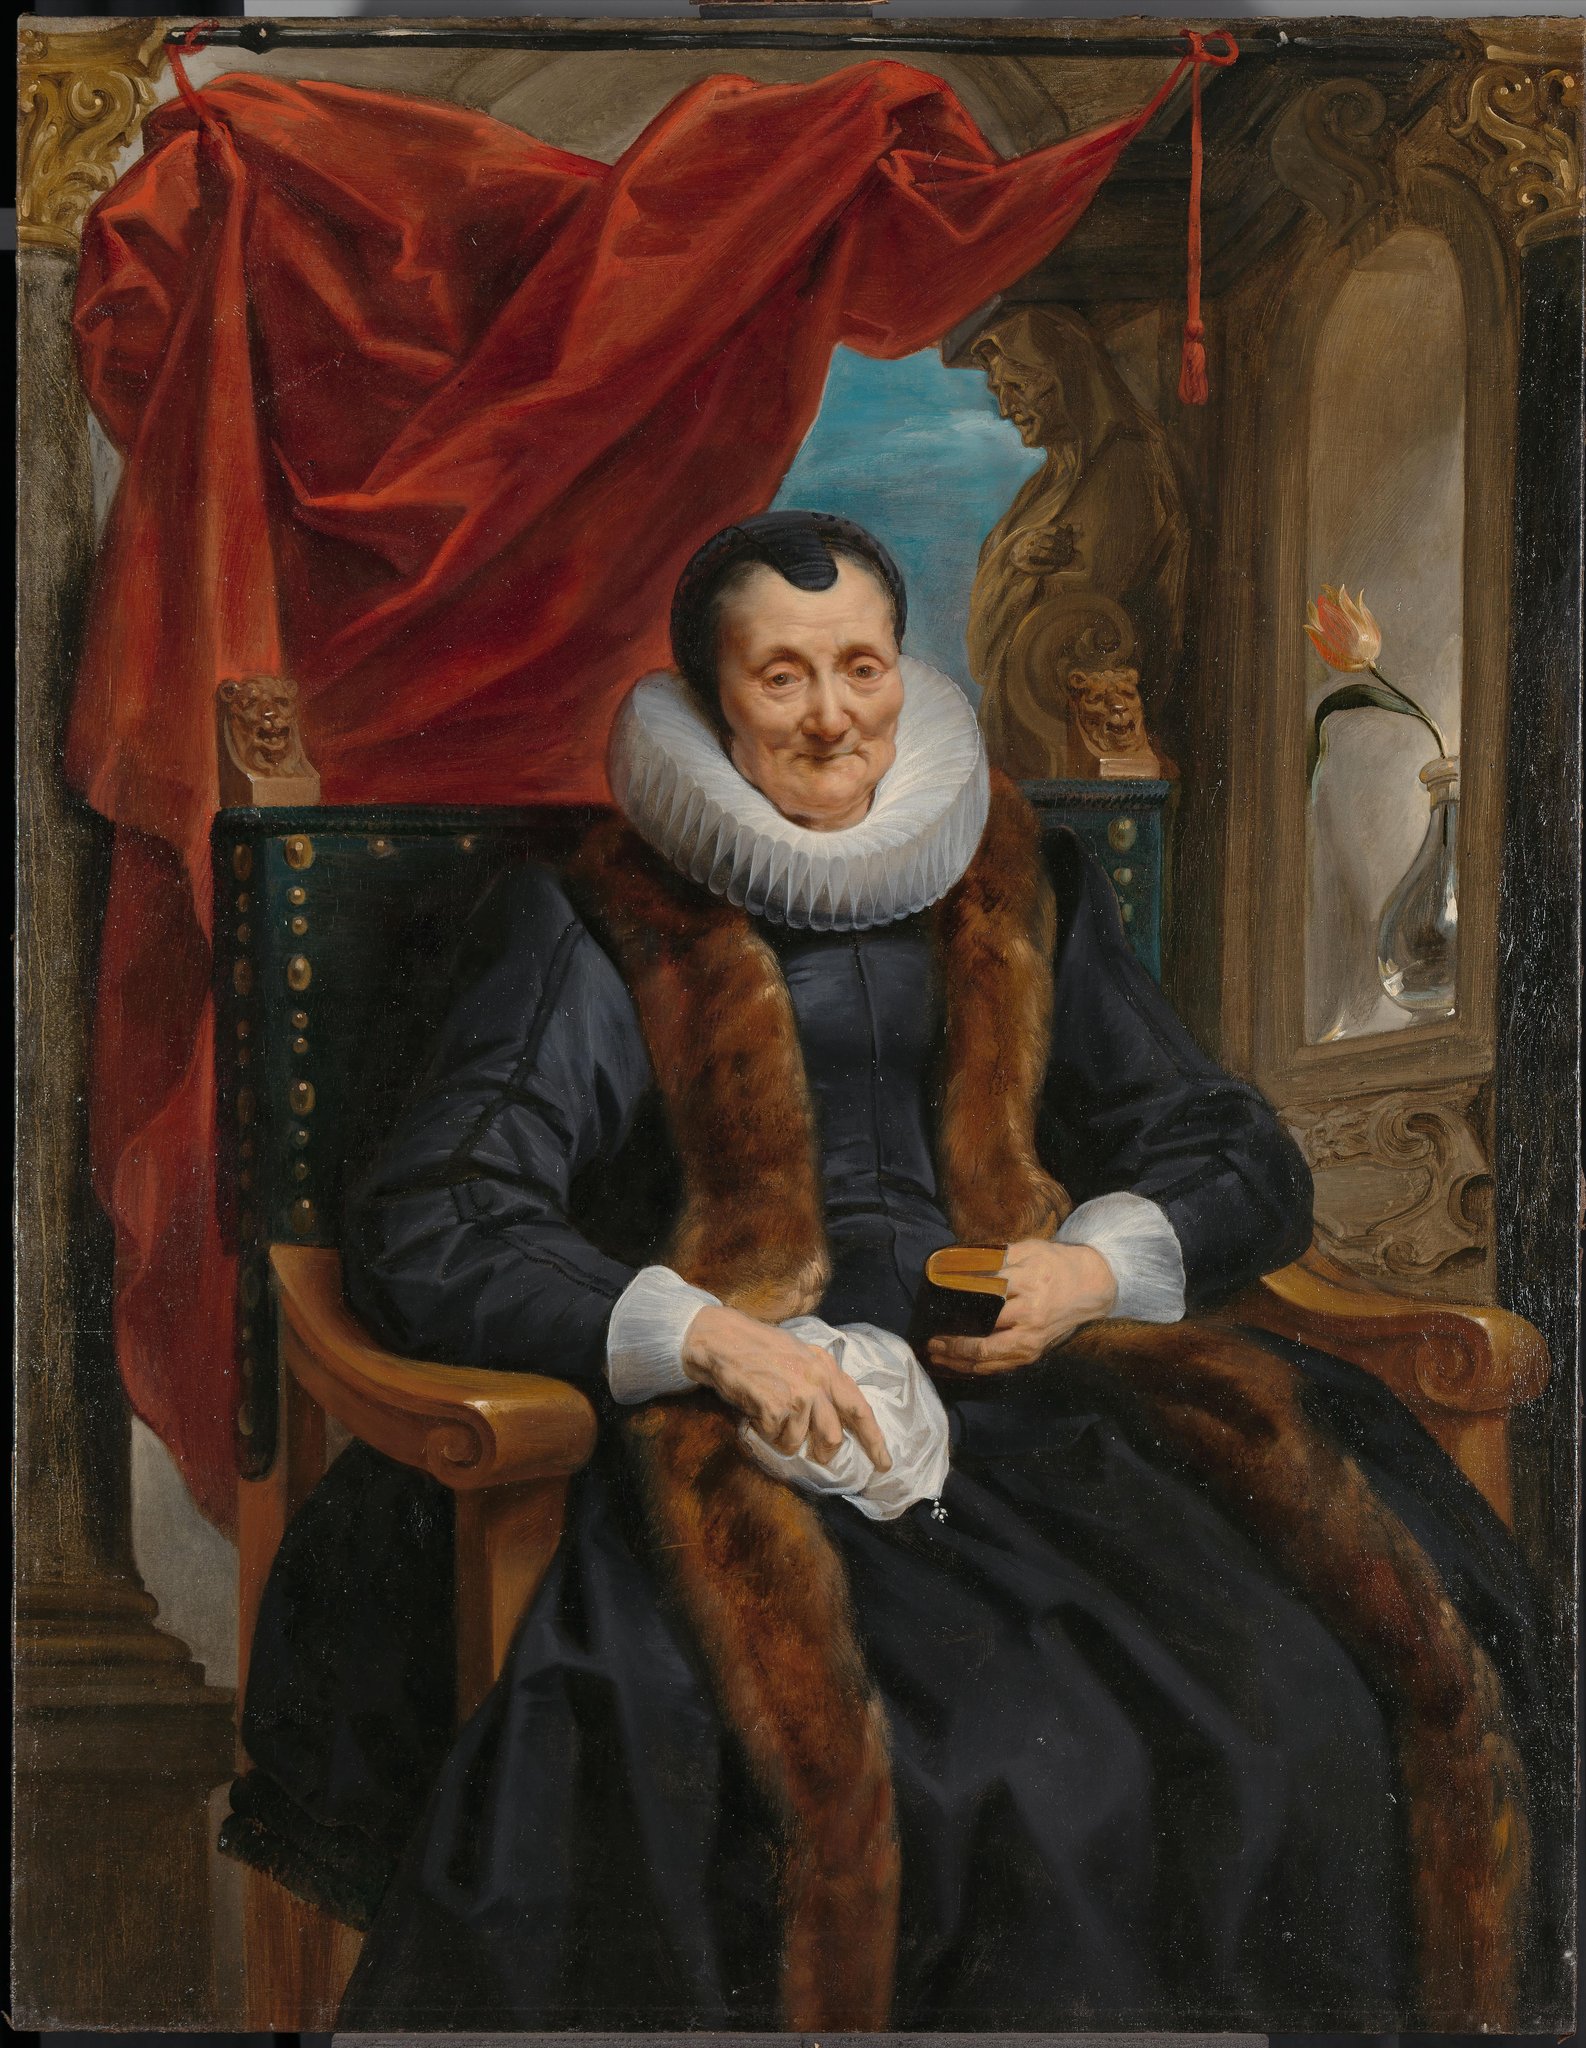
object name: painting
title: Portrait of Magdalena de Cuyper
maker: jacques jordaens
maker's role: designer, draughtsman, painter, print maker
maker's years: 1593-1678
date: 1635-1636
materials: canvas, oil, paint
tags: historical persons - bb - woman, handkerchief, old woman, other hybrid forms in the shape of a pillar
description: Magdalena de Cuyper is portrayed as a widow, with a black cap, a prayer book, and a flowering tulip. The latter two objects symbolize her piety, and transience. She and her husband had a successful silk cloth business, which Magdalena continued to run after his death. The style of her portrait is the same as that of those of her son and daughter-in-law. After her death, they hung the portrait along with theirs.